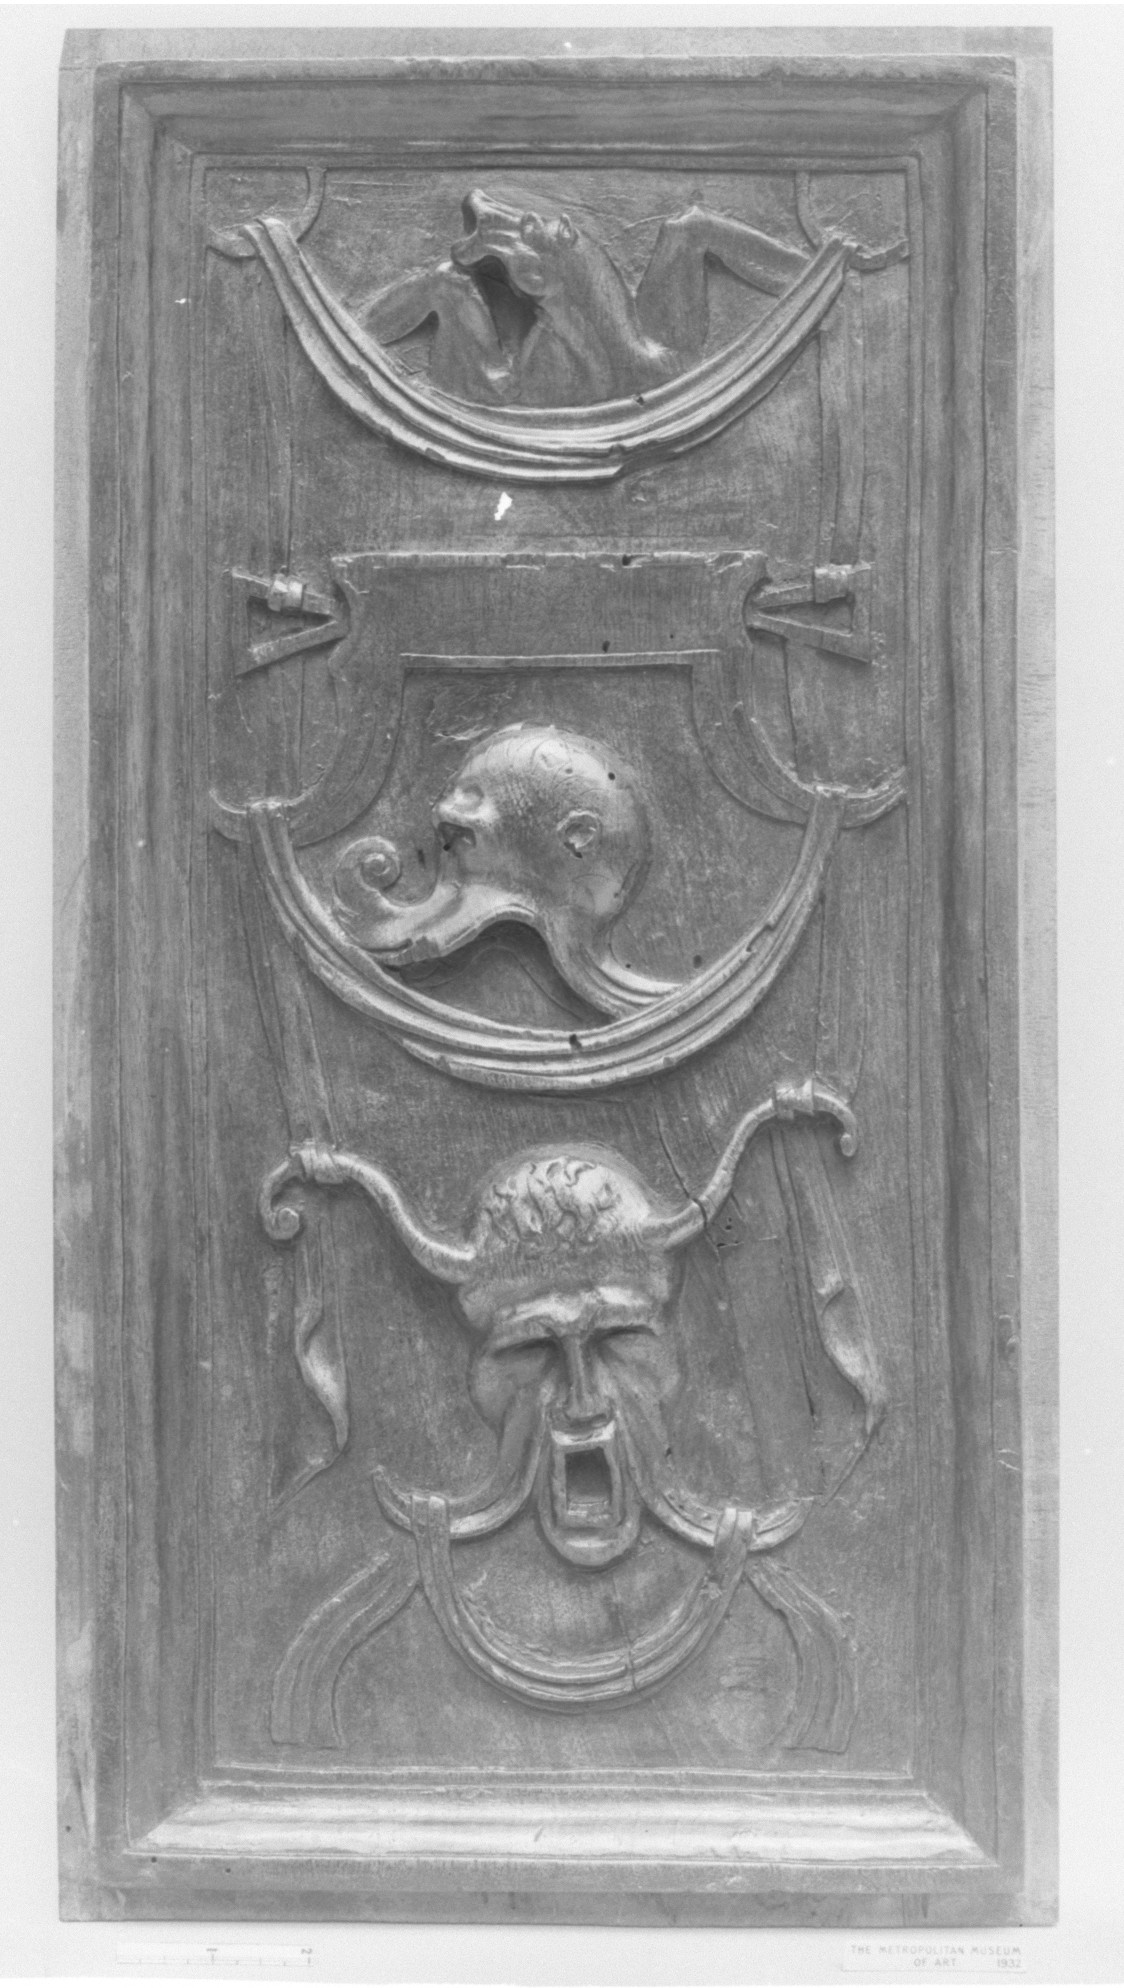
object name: panel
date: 1501-1600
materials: wood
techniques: carving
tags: masks